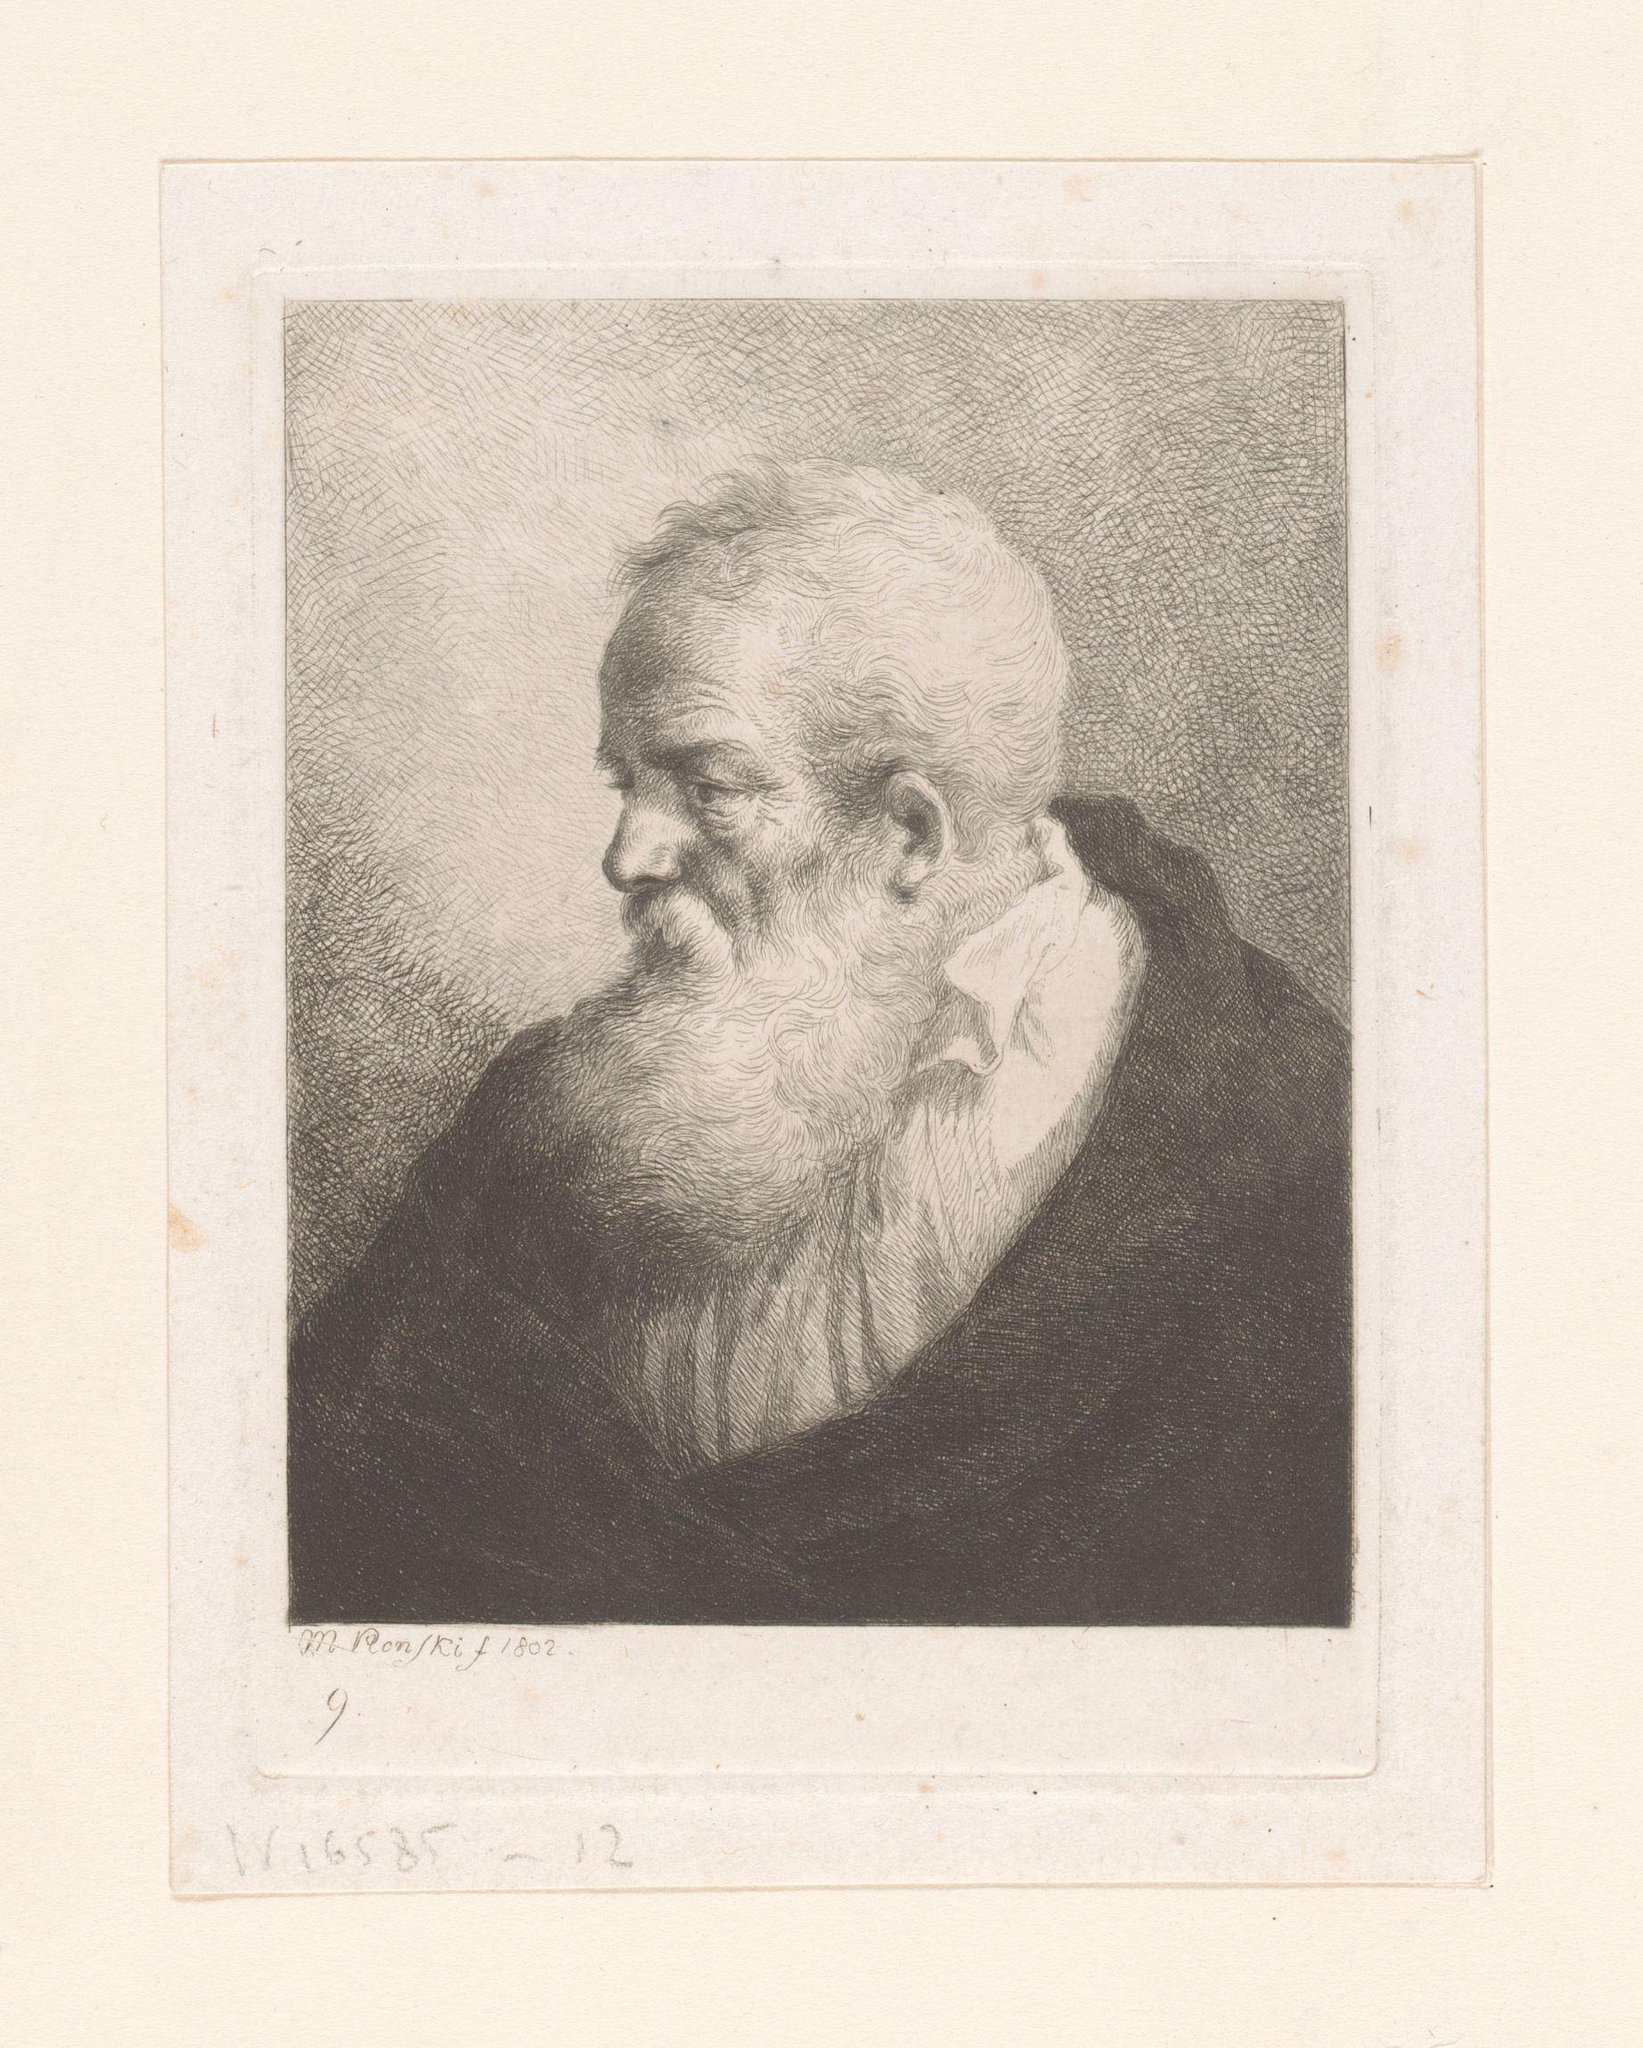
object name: print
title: Portret van een onbekende man met baard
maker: michał płoński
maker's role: print maker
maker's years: 1778-1812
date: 1802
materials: paper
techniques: etching, intaglio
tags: anonymous historical person portrayed alone, beard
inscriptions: collector's mark: Lugt 2228